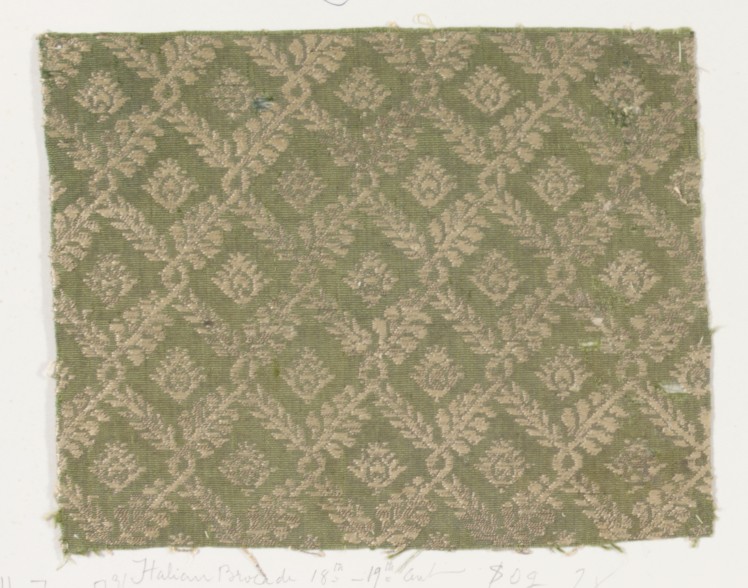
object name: fragment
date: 1701-1900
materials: metal thread, silk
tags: leaves